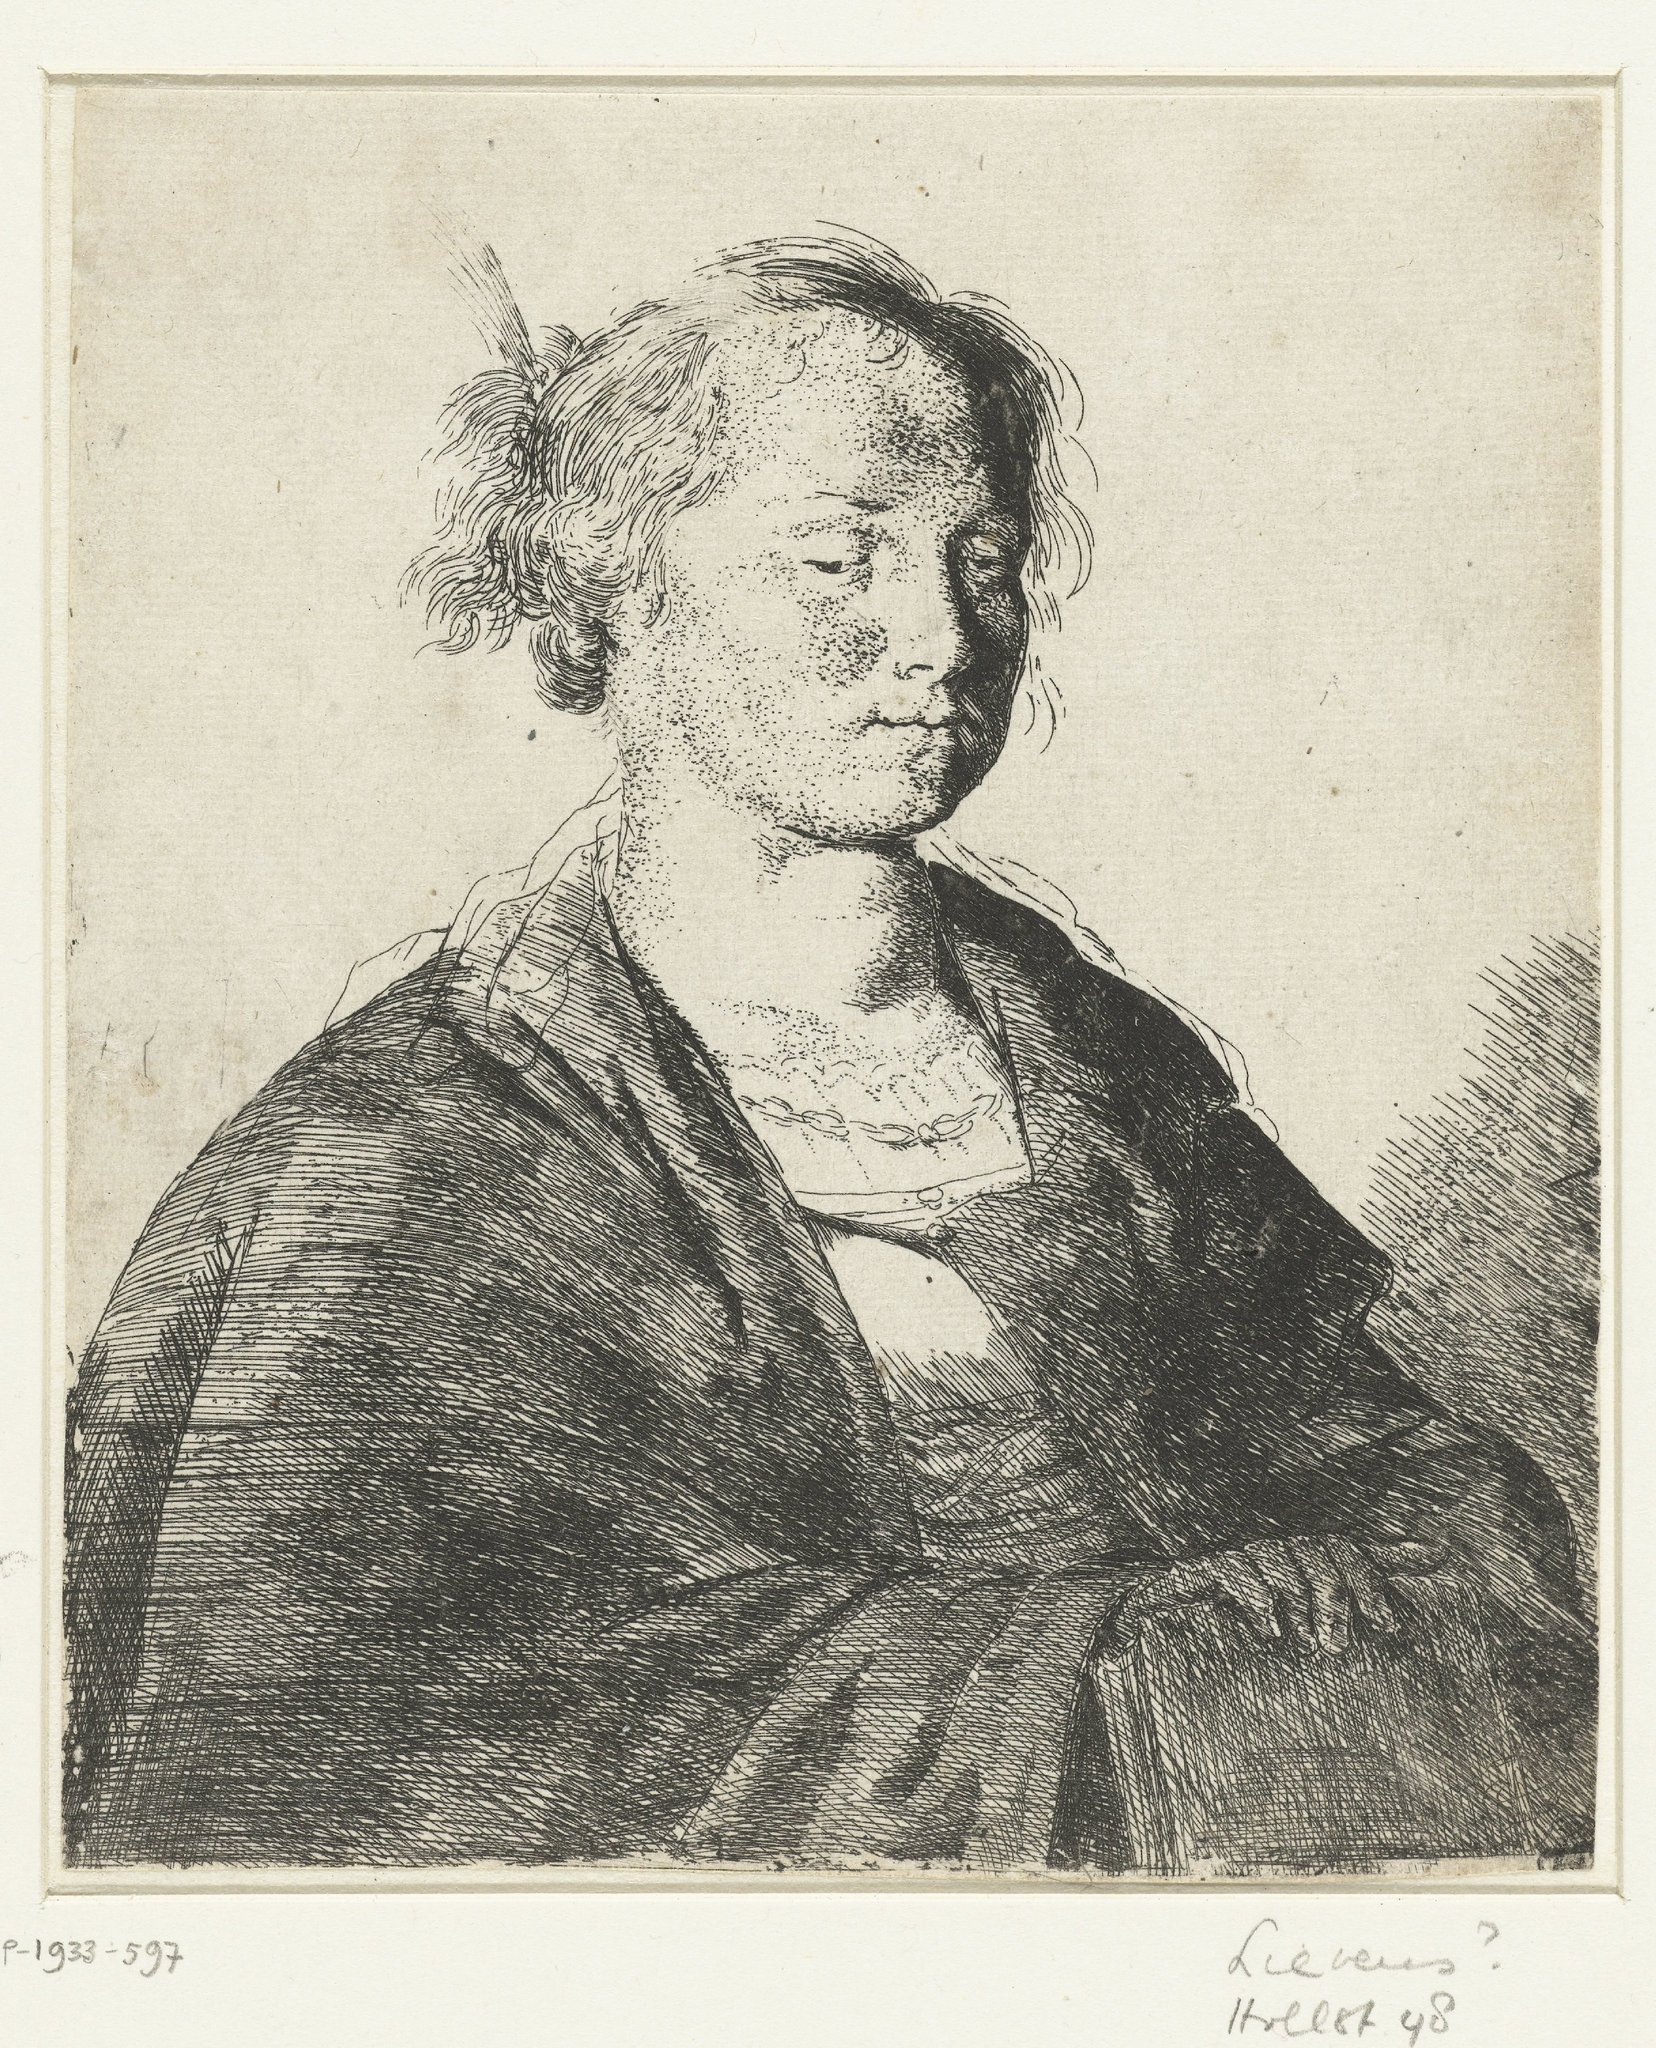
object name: print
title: Jonge vrouw met boek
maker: jan lievens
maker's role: draughtsman, painter, print maker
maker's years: 1607-1674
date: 1617-1674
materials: paper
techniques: etching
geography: netherlands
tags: adolescent, young woman, maiden (+ three-quarter view)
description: Buste van een jongevrouw, in haar rechterhand een boek.